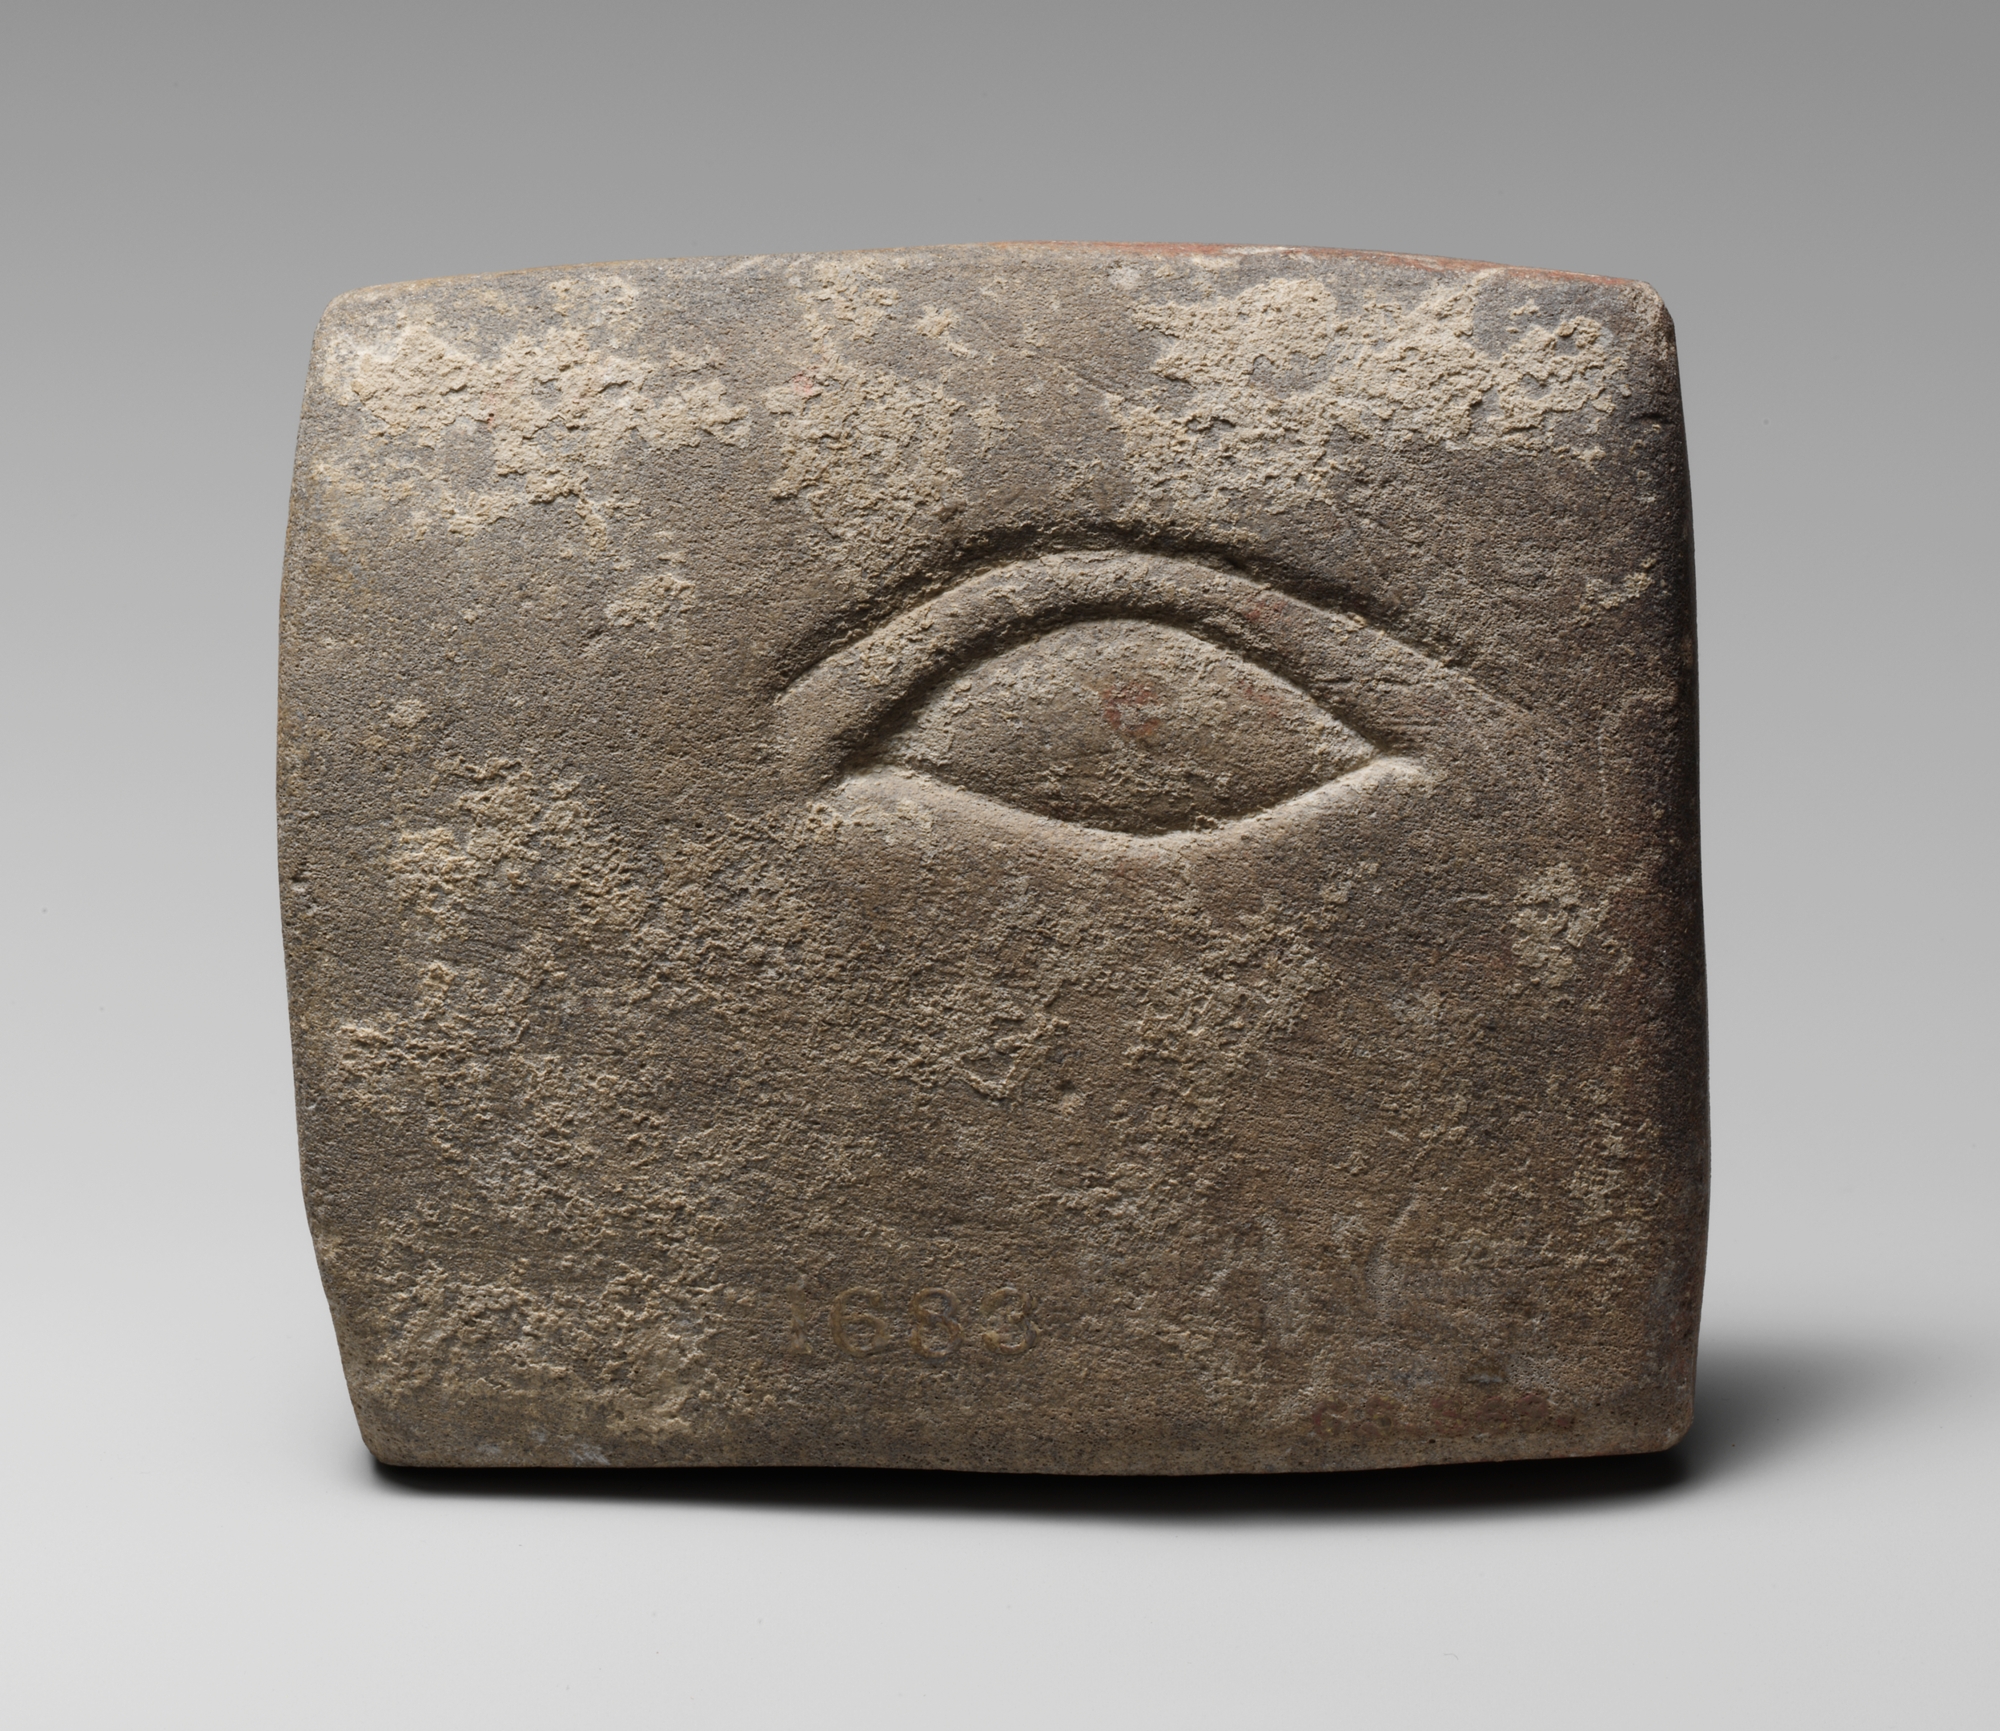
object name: votive relief of an eye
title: Stone votive relief of an eye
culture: cypriot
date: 400-201 BCE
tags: eyes